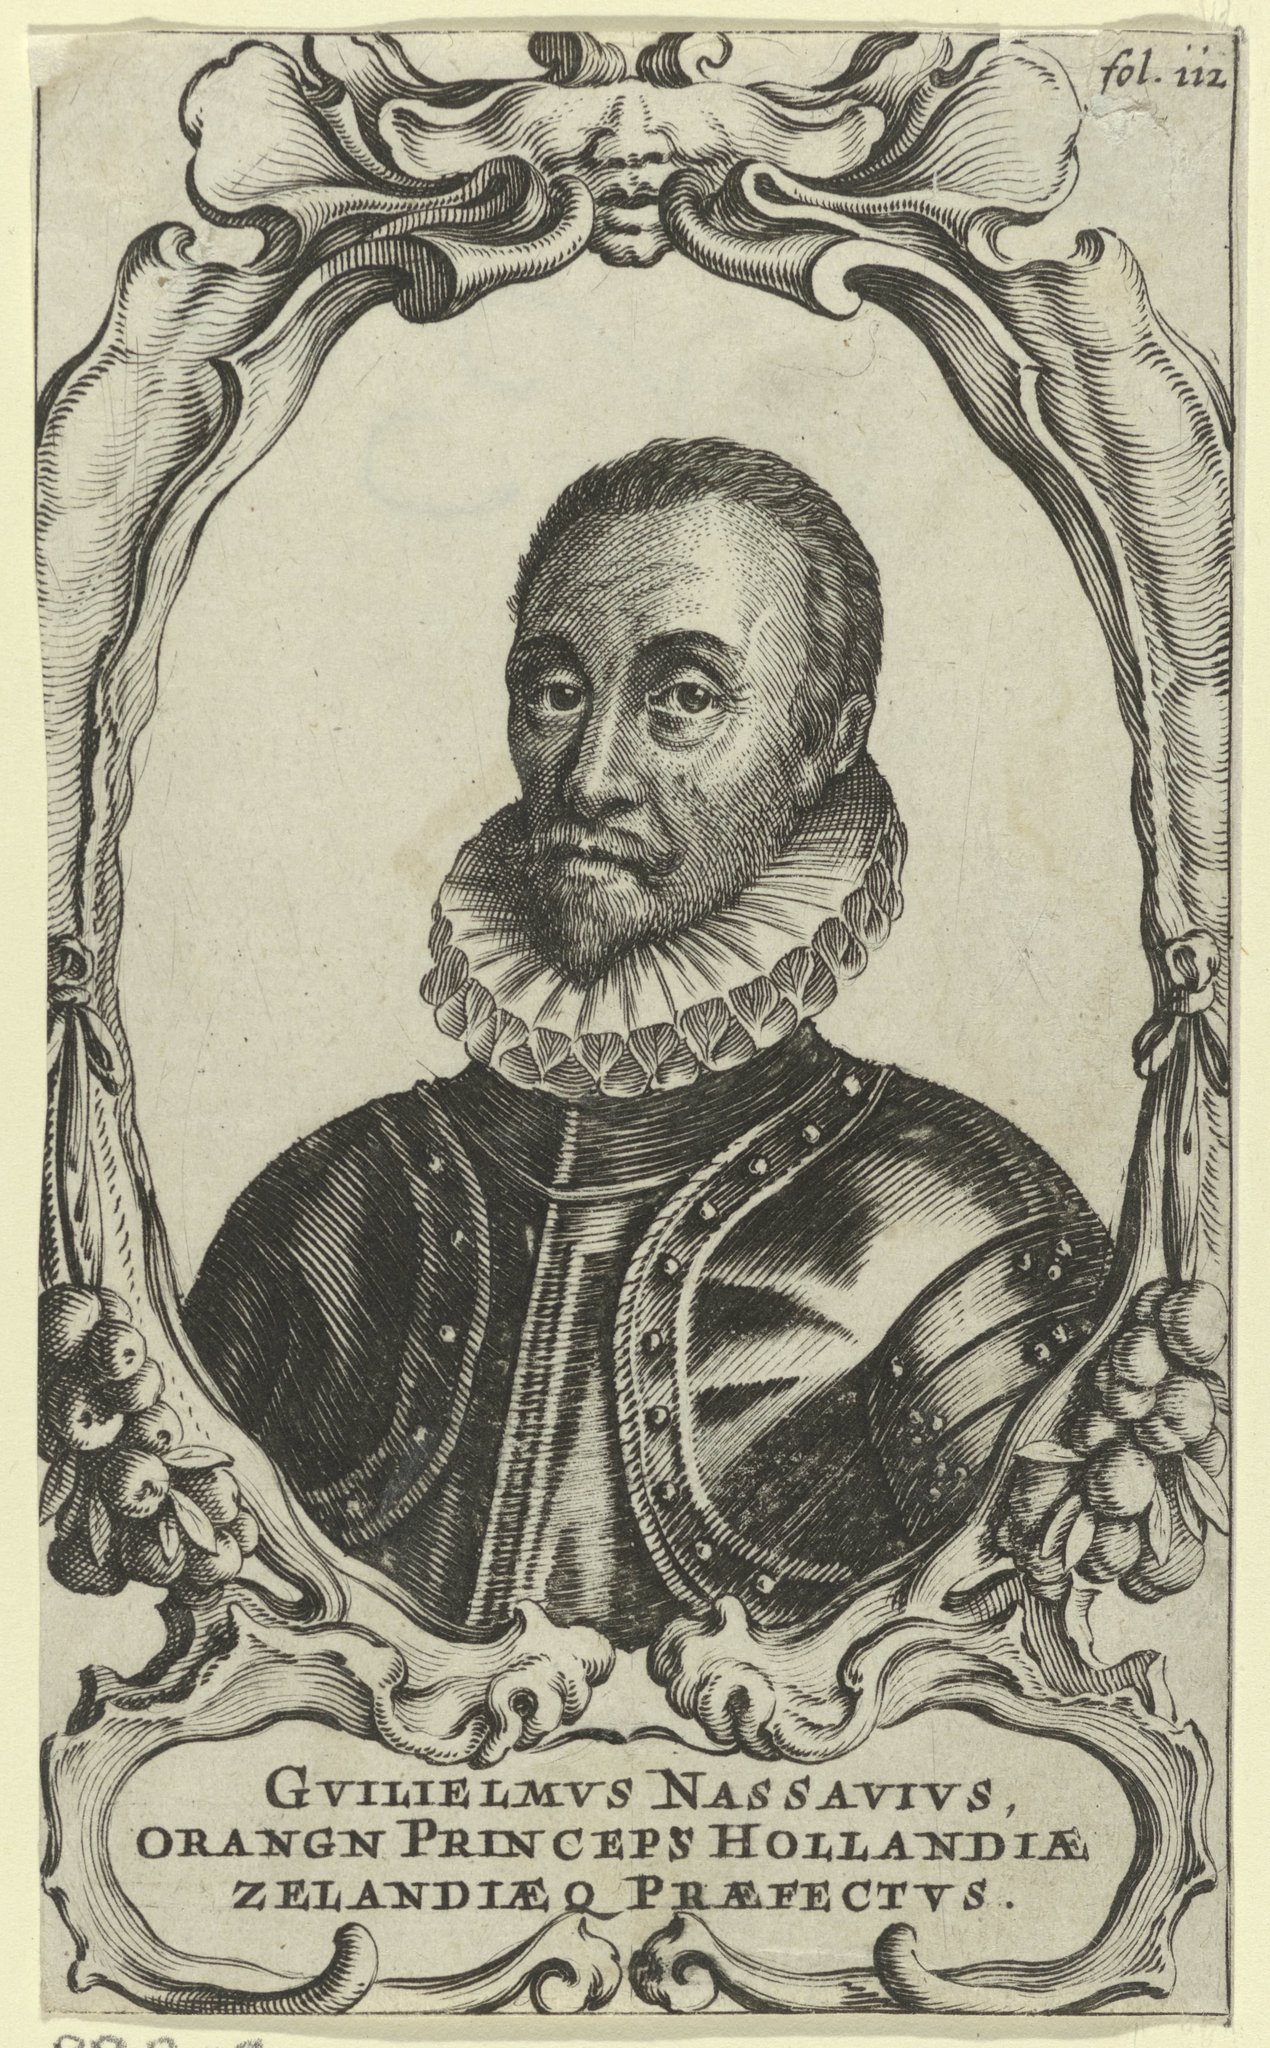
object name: book illustration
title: Portret van Willem I, prins van Oranje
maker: Anonymous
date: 1600-1699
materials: paper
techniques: engraving, etching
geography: low countries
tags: delft, william i (prince of orange)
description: De hier vermelde titel verwijst naar de hoogst verkregen titel van de geportretteerde, niet per se naar de titel die de geportretteerde op deze voorstelling draagt.